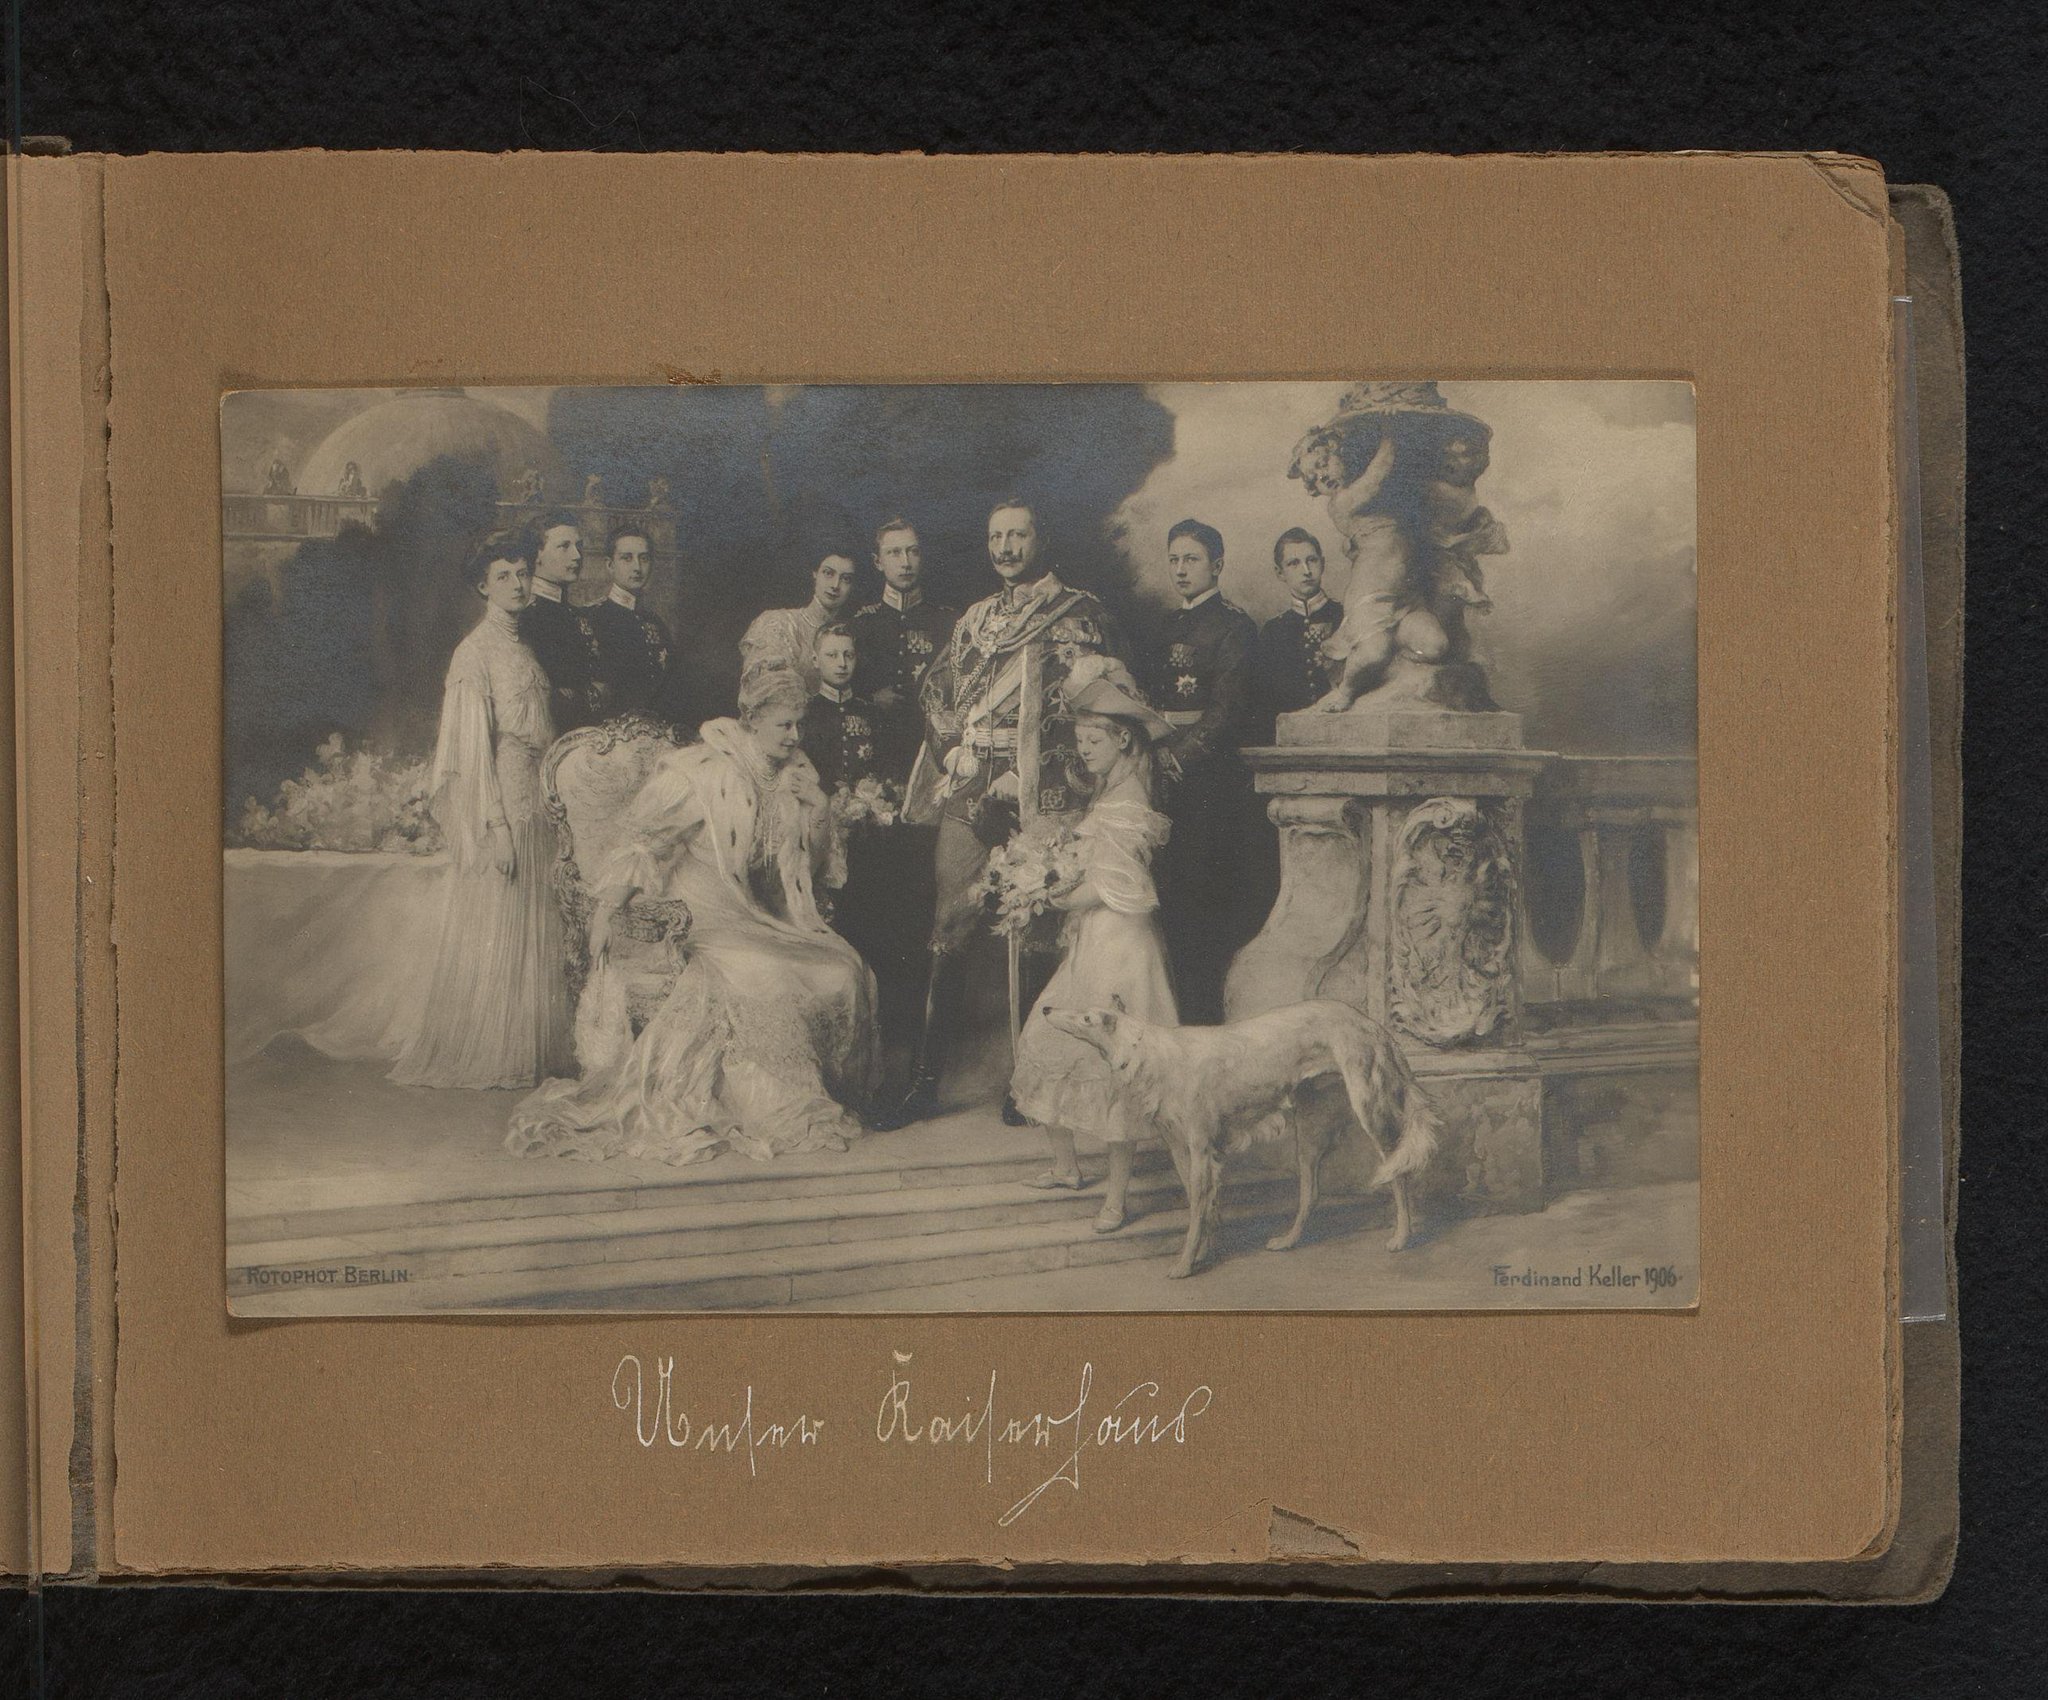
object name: photograph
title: Unser Kaiserhaus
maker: ferdinand keller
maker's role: fotograaf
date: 1906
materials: paper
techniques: gelatin silver print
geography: berlin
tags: wilhelm ii (keizer van duitsland), augusta victoria (keizerin van duitsland), family of a ruler, and court, anonymous historical persons portrayed in a group, in a group-portrait, berlin